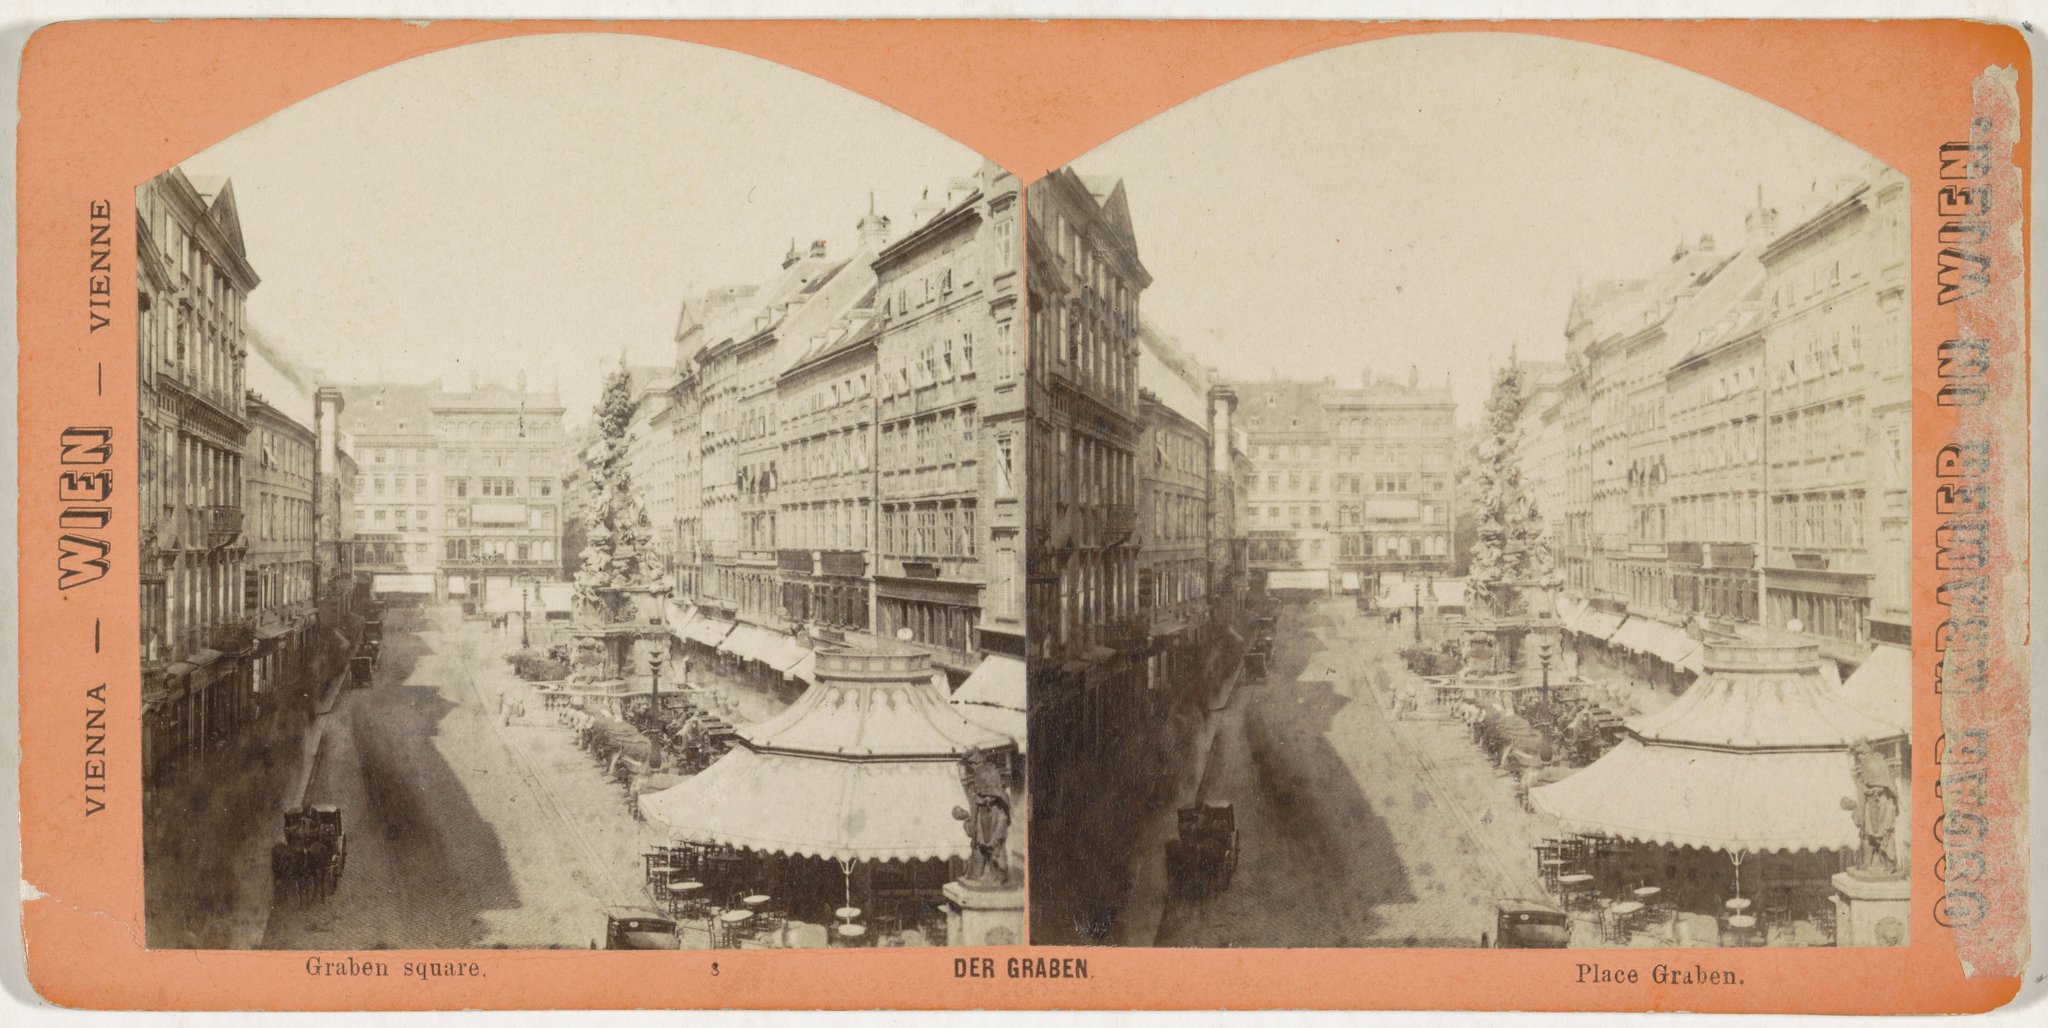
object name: stereograph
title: Graben square. Der Graben. Place Graben.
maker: oscar krämer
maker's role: publisher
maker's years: 1835-1892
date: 1868-1877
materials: cardboard, paper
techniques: albumen print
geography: vienna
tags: square, place, circus, etc.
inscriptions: inscription: ‘No51 WGP’, address: ‘Kohlmarkt No 18.’, inscription: ‘Vervielfältigung vorbehalten.’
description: Waarschijnlijk is deze foto gemaakt vanuit Graben 9, waar Oscar Kramer tussen 1868 en 1870 zijn fotostudio had.